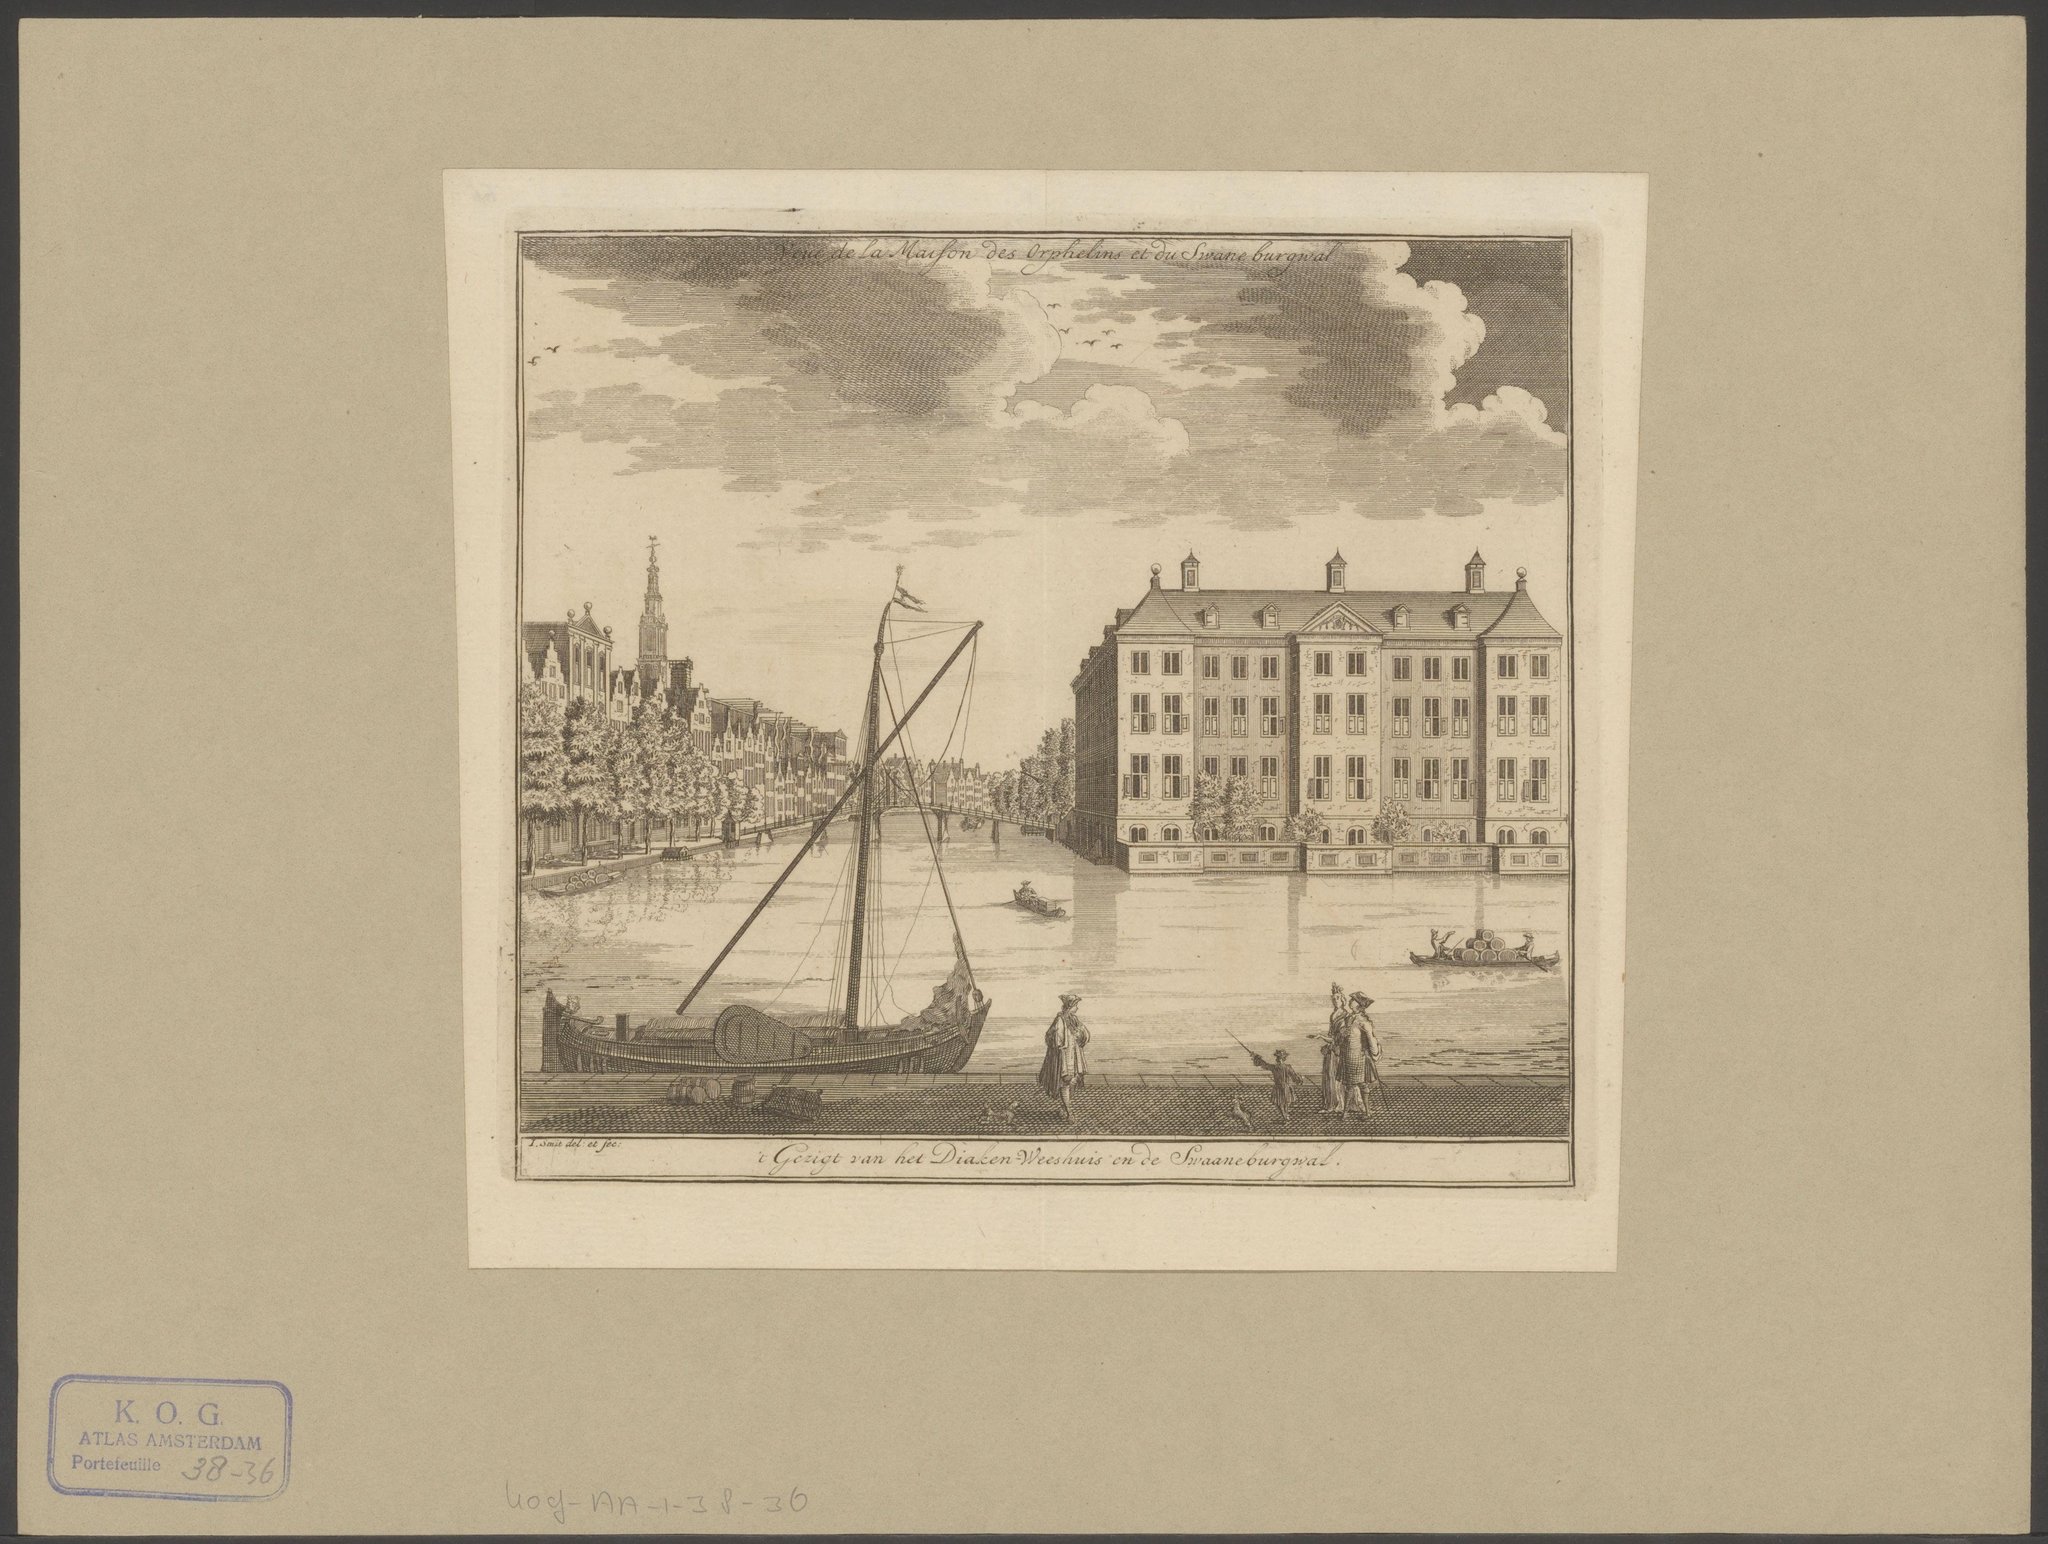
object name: print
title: Veüe de la Maison des Orphelins et du Swane burgwal / 't Gezigt van het Diaken-Weeshuis en de Swaaneburgwal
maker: hendrik de leth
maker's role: draughtsman, print maker, publisher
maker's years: 1703-1766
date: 1740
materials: paper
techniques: engraving, etching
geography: amsterdam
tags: ships (in general), orphanage, canals, waters (in city) (+ city(-scape) with figures, staffage)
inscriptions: collector's mark: Lugt 1641b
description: Prent mogelijk uit: Description de la fameuse ville d'Amsterdam (...) / Afbeeldinge van de wydt-vermaarde stadt Amsterdam (...). Amsterdam: Hendrik de Leth, [ca. 1740].